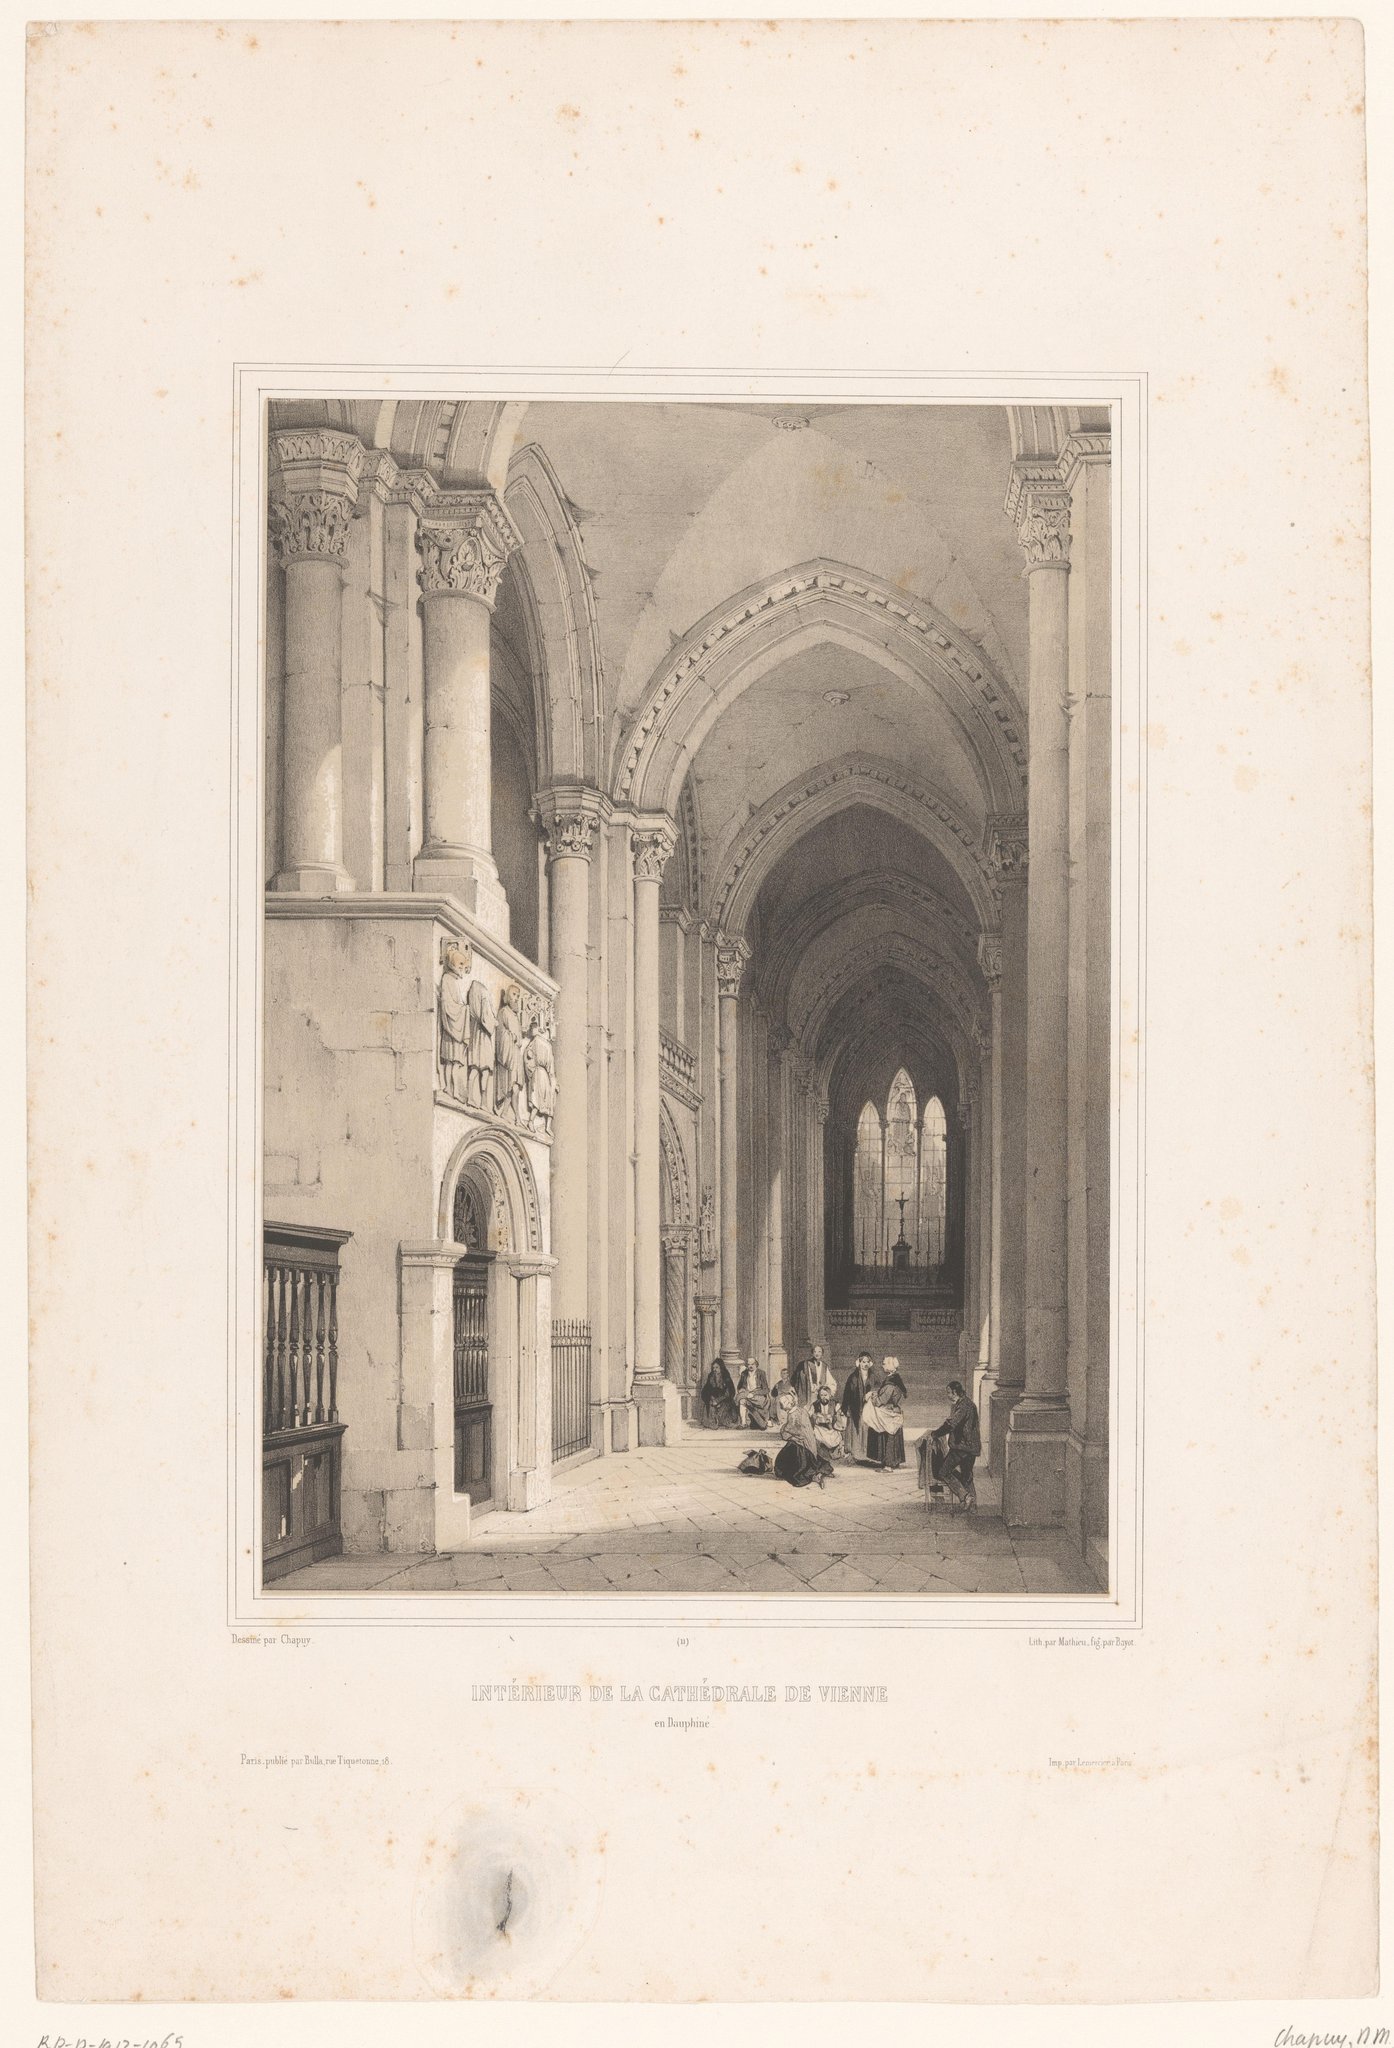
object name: print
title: Interieurs van monumenten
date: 1843-1848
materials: paper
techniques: tone lithography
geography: paris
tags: interior of church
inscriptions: collector's mark: Lugt 2228a